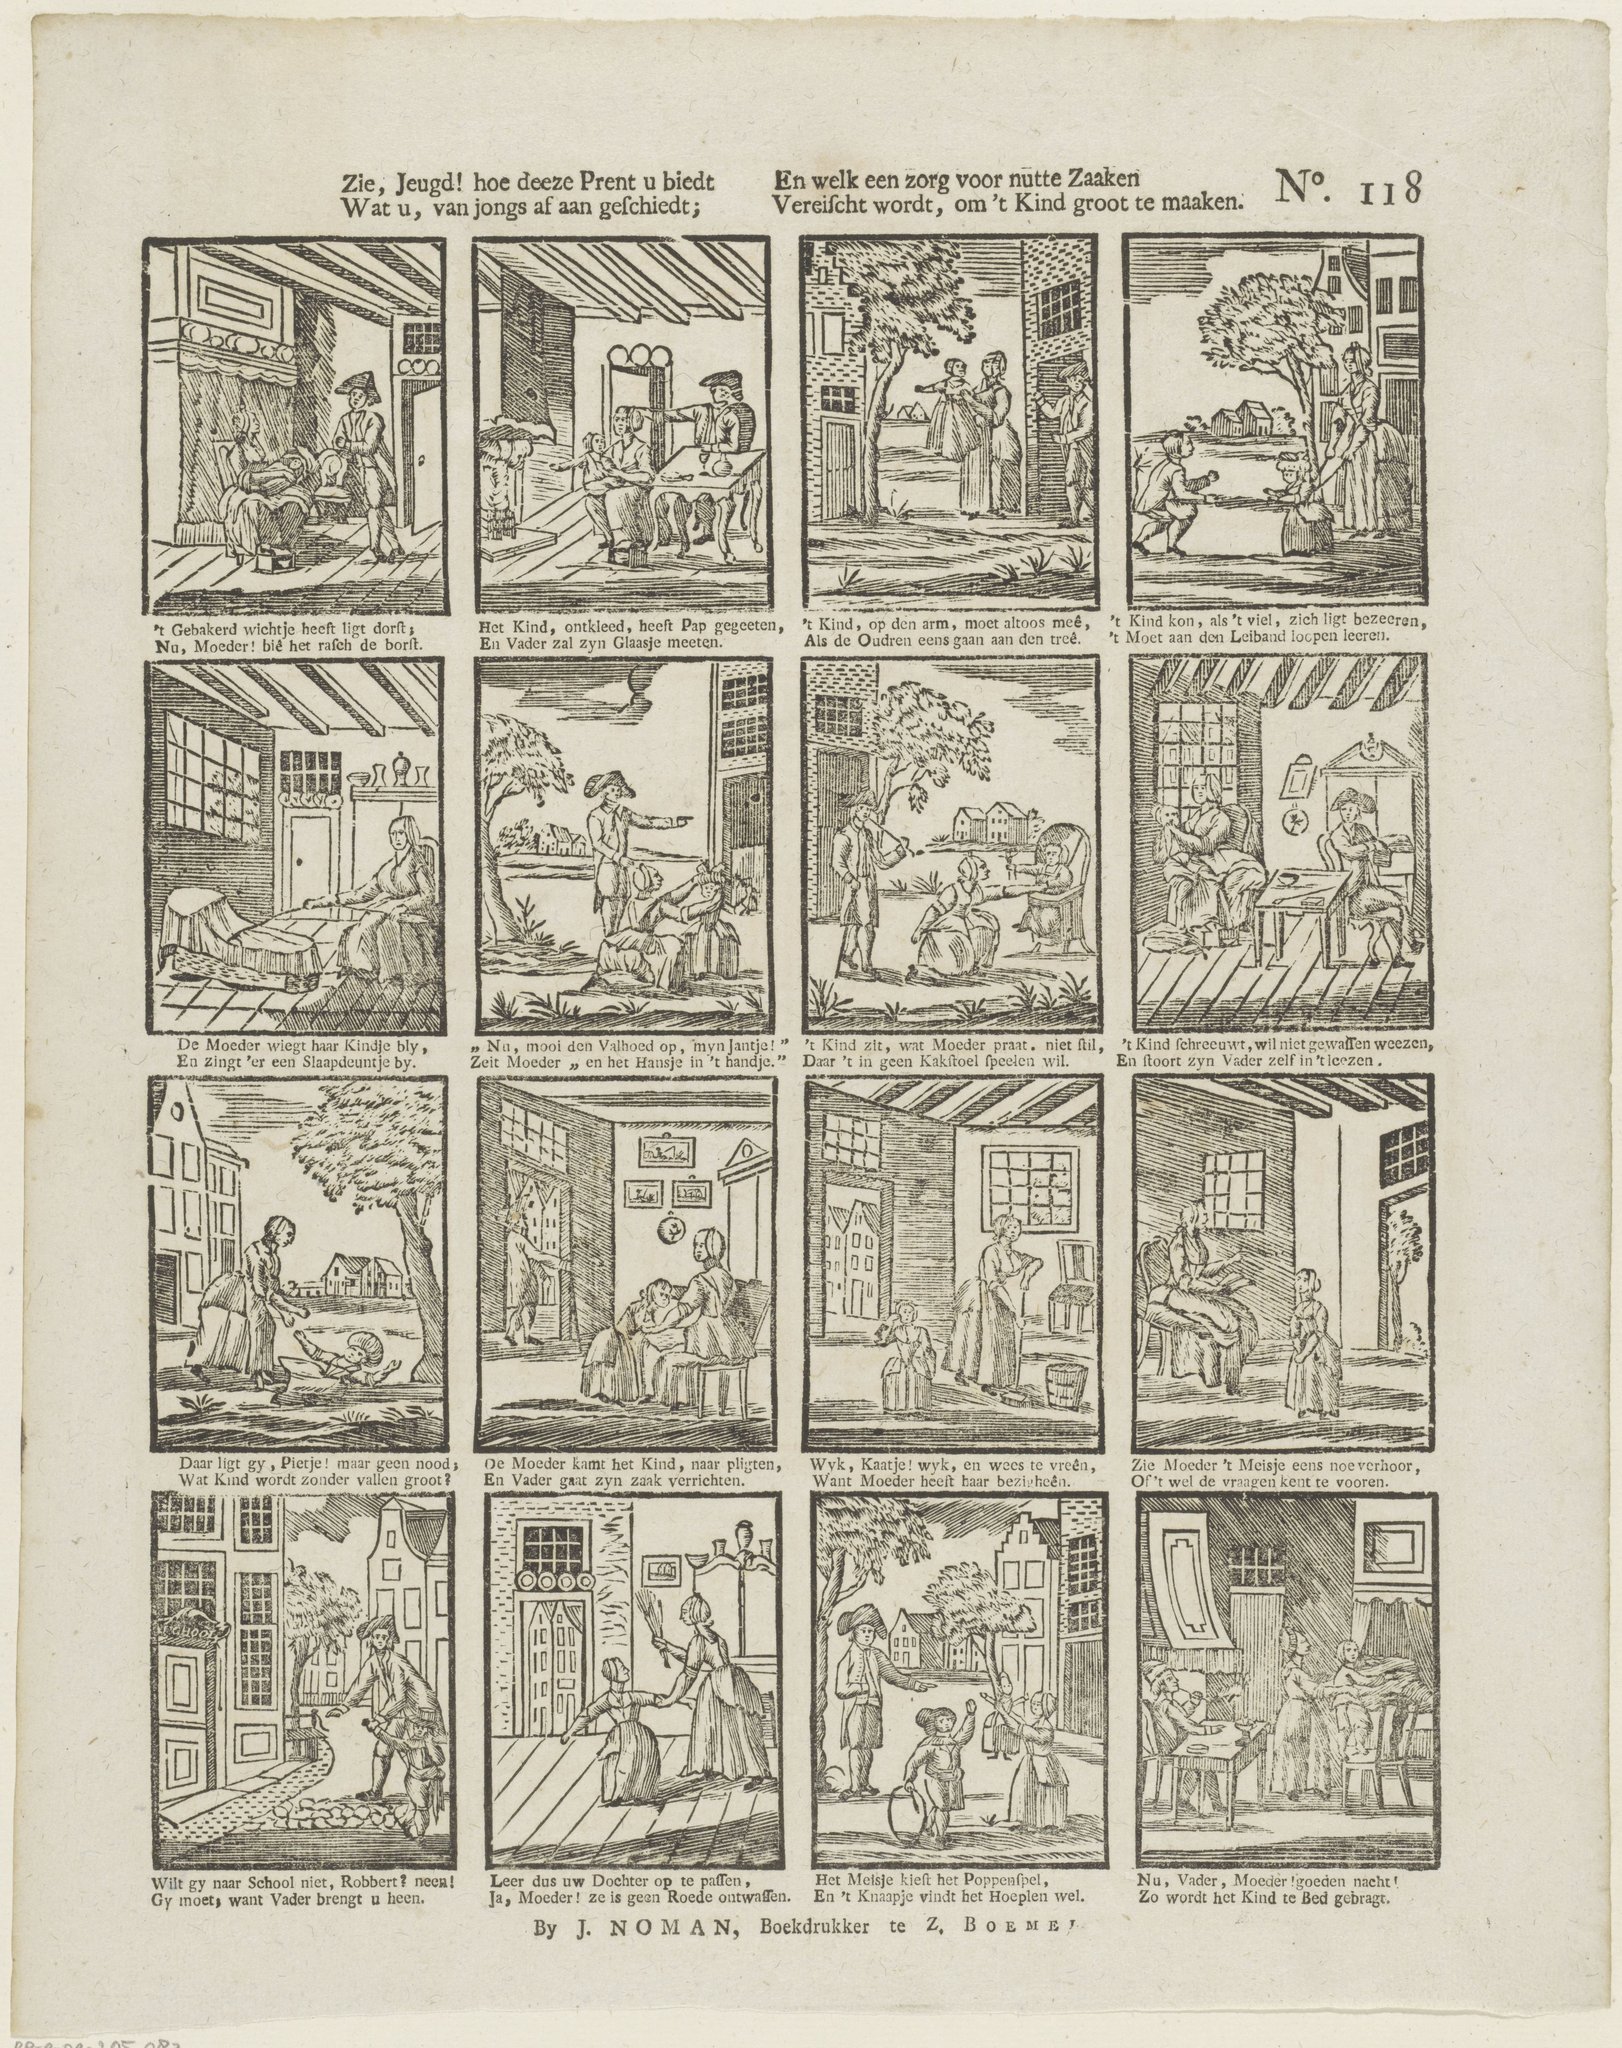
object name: print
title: Zie, jeugd! hoe deeze prent u biedt / Wat u, van jongs af aan geschiedt; / En welk een zorg voor nutte zaaken / Vereischt wordt, om 't kind groot te maaken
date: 1806-1830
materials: paper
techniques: letterpress printing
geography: zaltbommel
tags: child, growing up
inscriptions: collector's mark: Lugt 2760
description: Blad met 16 voorstellingen over de opvoeding van een kind. Onder elke afbeelding een tweeregelig vers. Genummerd rechtsboven: No. 118.